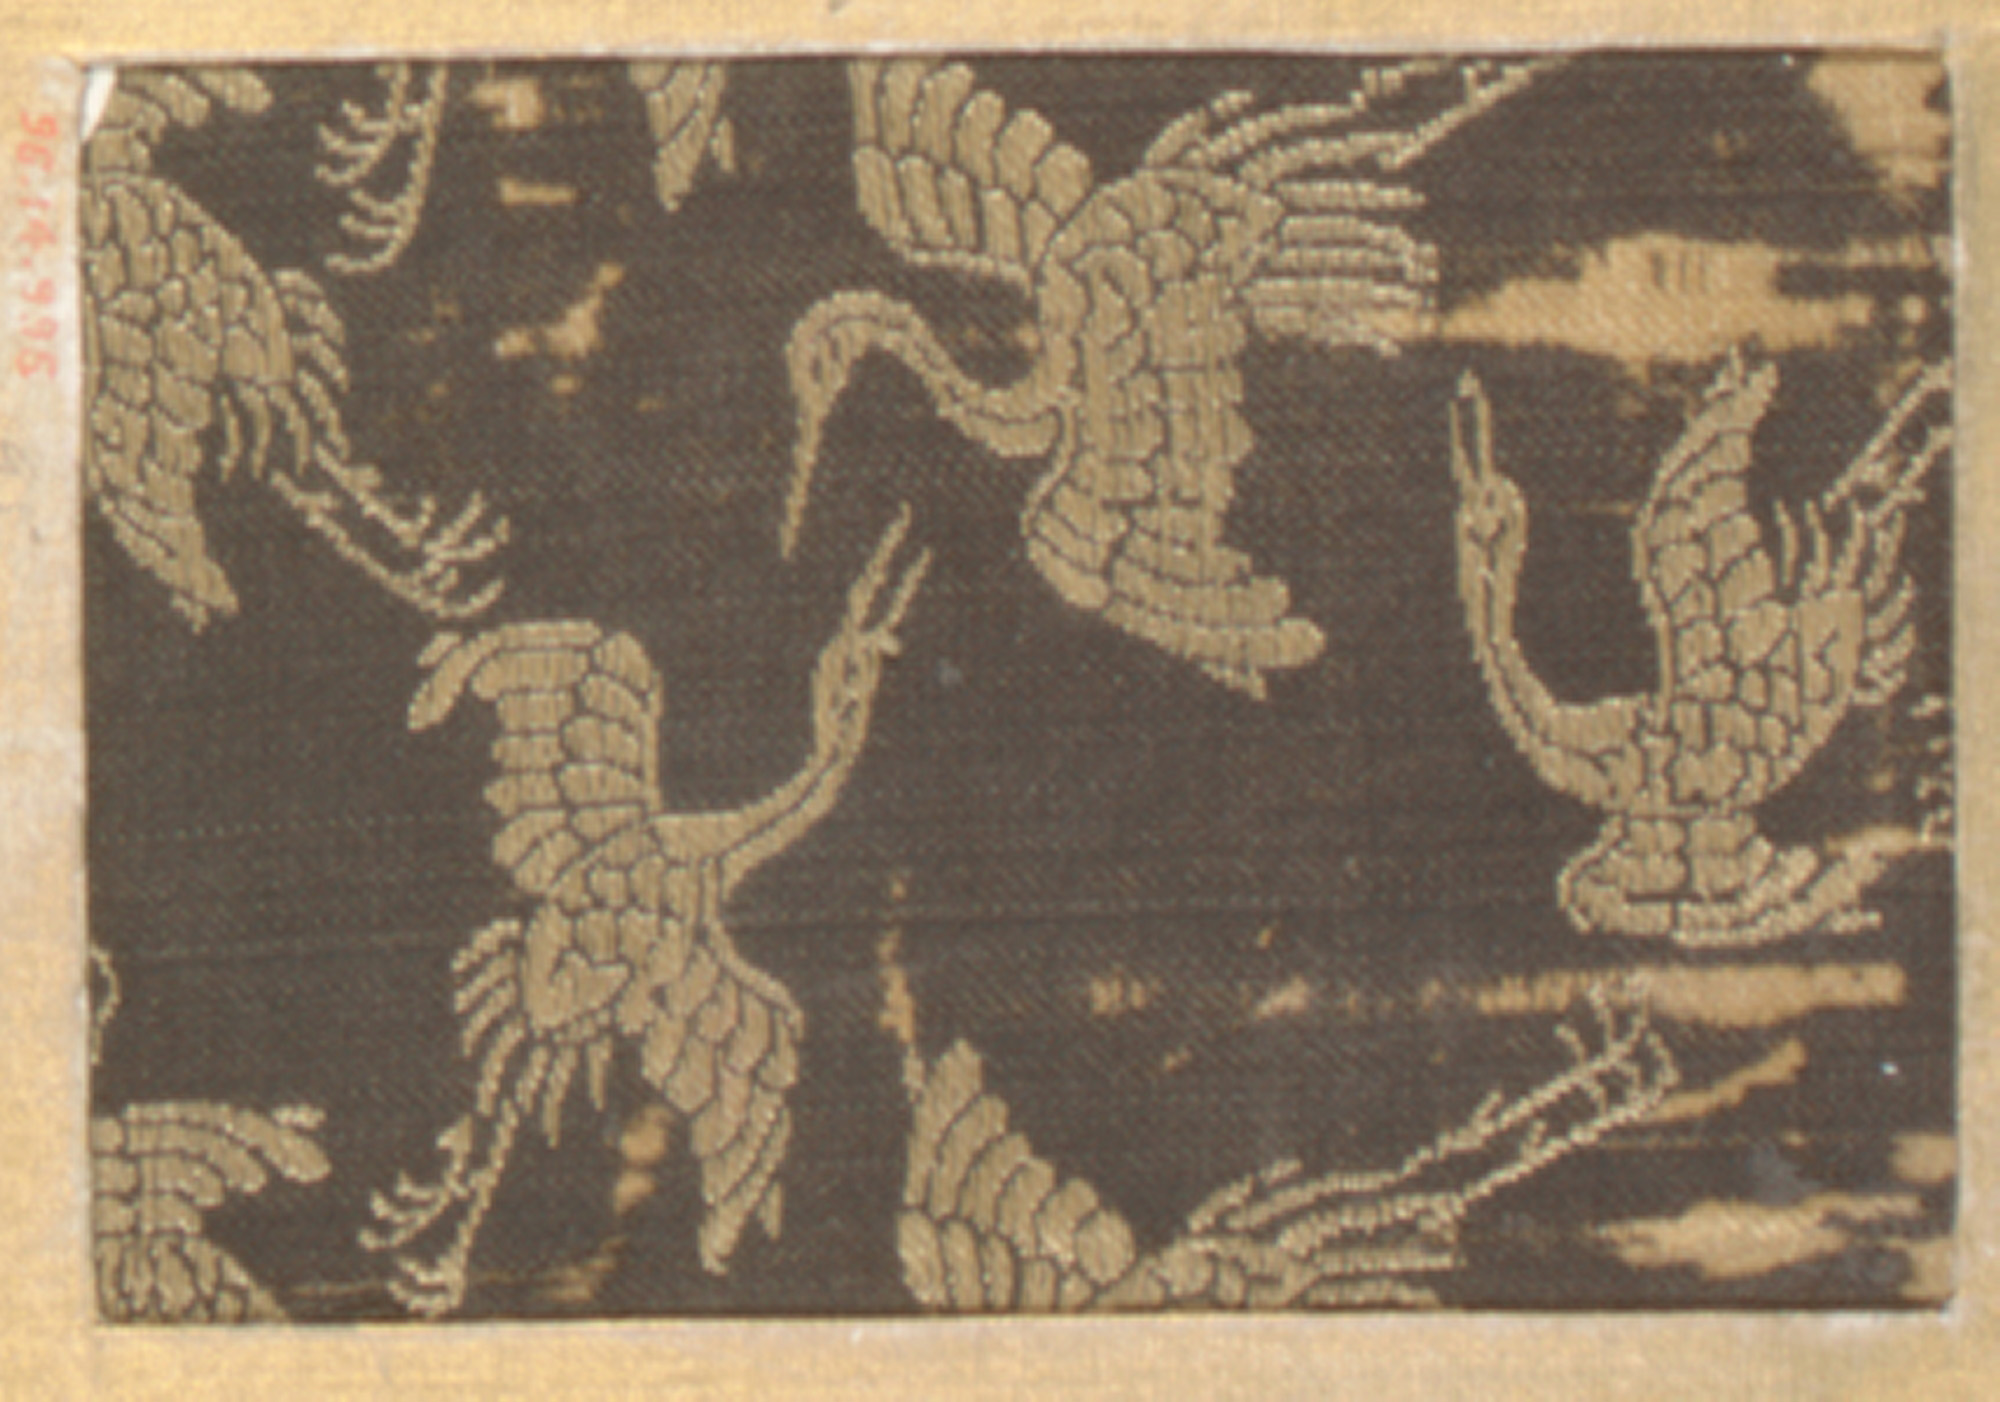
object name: piece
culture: japanese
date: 1701-1900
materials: silk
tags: cranes